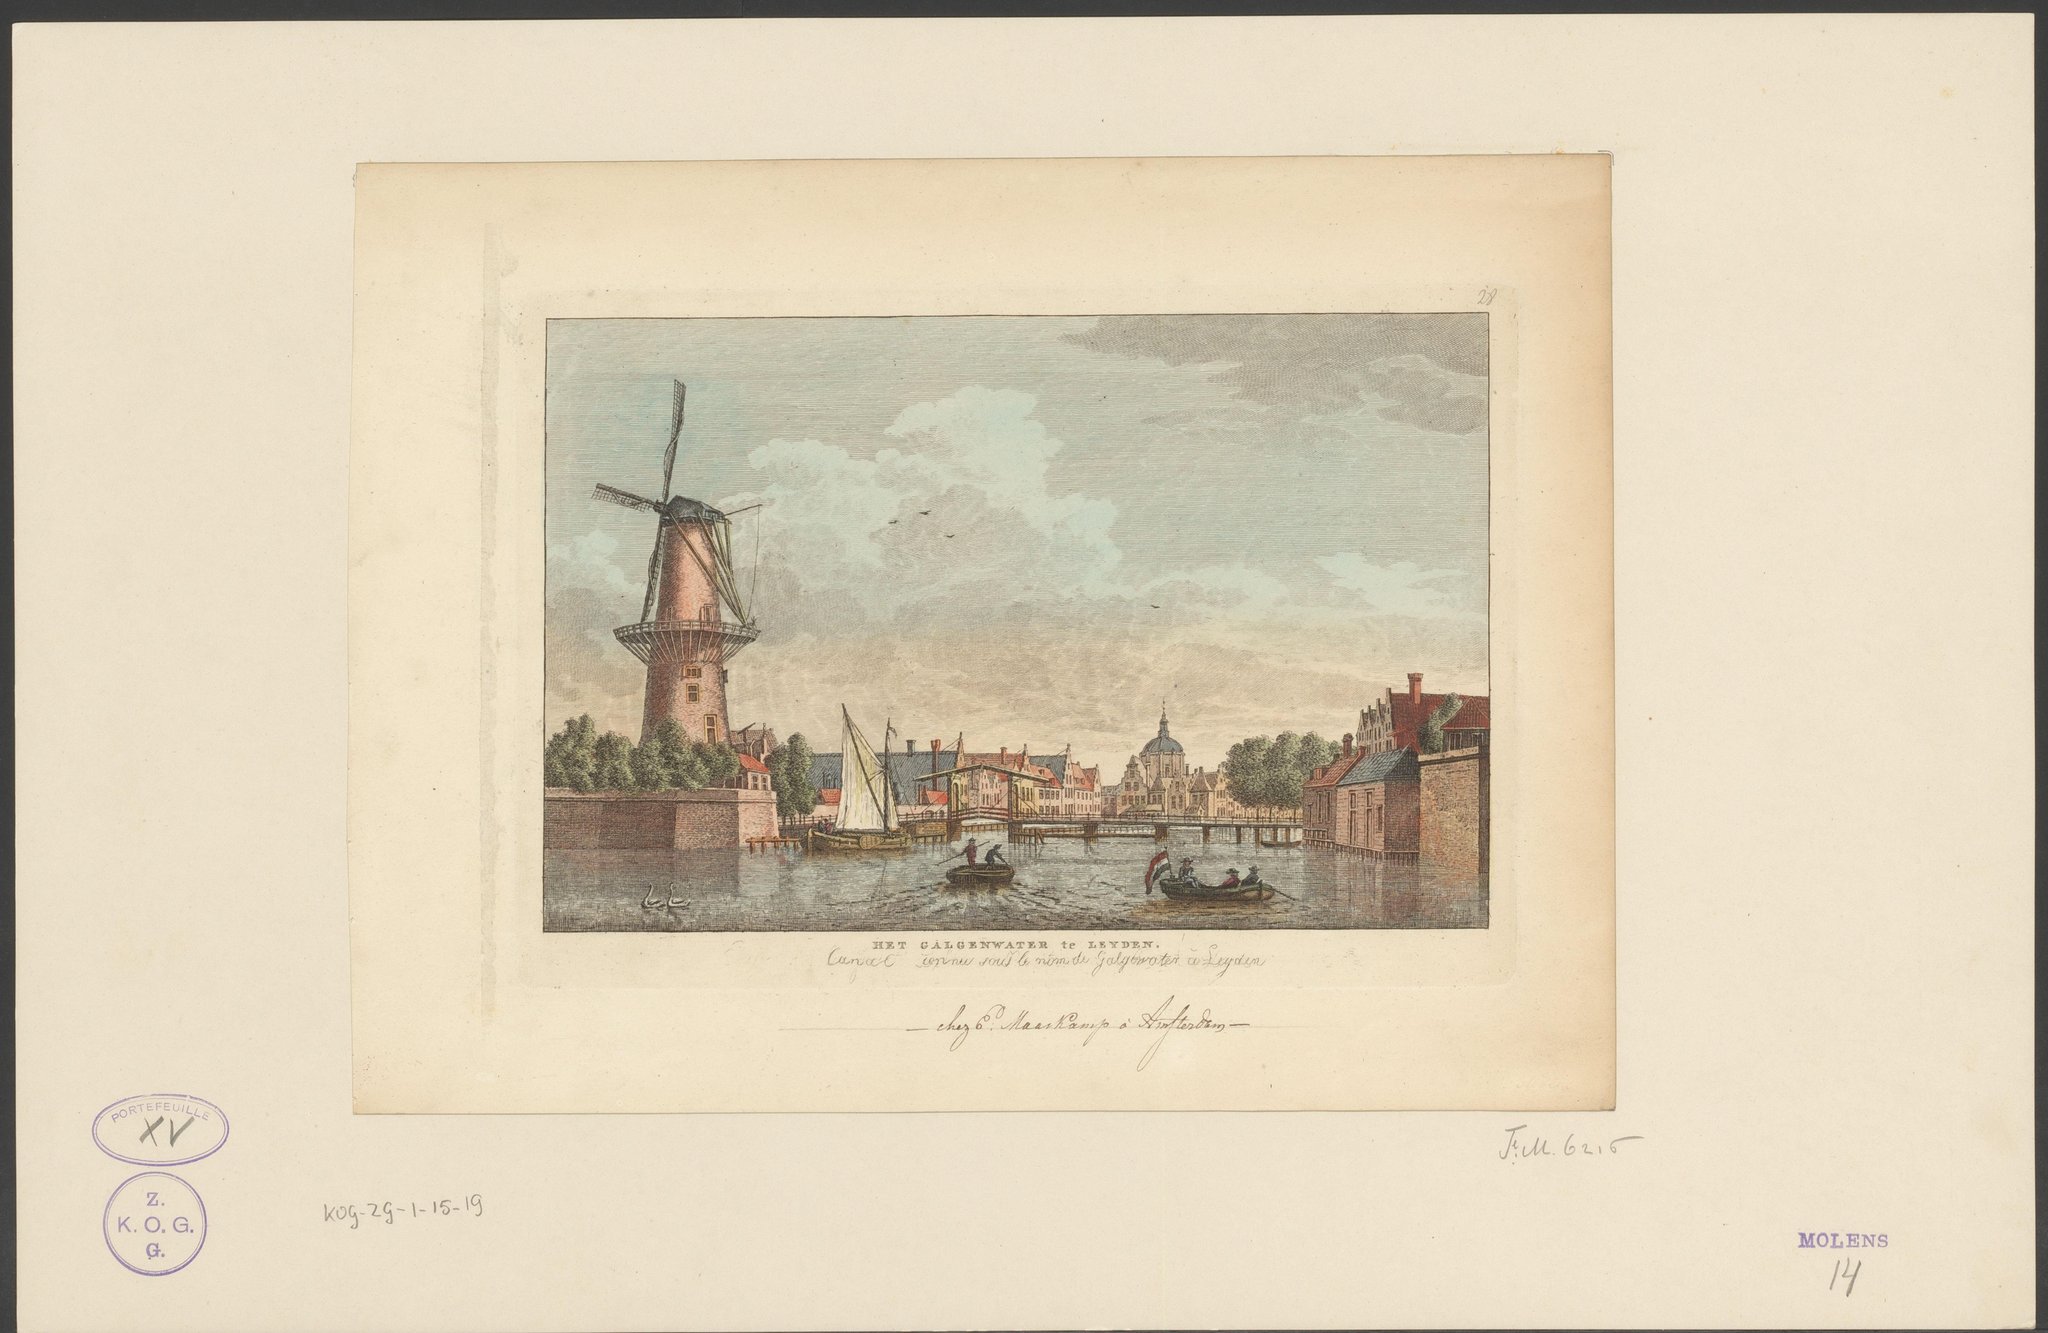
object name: print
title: Galgewater te Leiden, ca. 1790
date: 1786-1792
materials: paper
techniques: engraving, etching, hand coloring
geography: amsterdam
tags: windmill, leiden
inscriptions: stamp, collector's mark: Lugt 1641, stamp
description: Huidige staat van prent uitgegeven als onderdeel van een plaatwerk uit ca. 1824-1825 met 74 (ongenummerde) platen van de belangrijkste topografische gezichten en verschillende zeden en gewoonten in het Verenigd Koninkrijk der Nederlanden, getiteld 'Tableau des principales vues des palais et édifices : représentations et des coutumes et usages, dans les provinces septentrionales du Royaume des Pays-Bas'. Eerdere staat gebruikt in: Vaderlandsche gezichten, of afbeeldingen van den tegenwoordigen staat der Vereenigde Nederlanden (…). Amsterdam: Hendrik Gartman, Willem Vermandel en Jan Willem Smit, 1786-1792. Uitgegeven in afleveringen met ieder een eigen bifolium en inhoudsopgave. Alle prenten in deze publicatie zijn gegraveerd door Carel Frederik Bendorp (I) en, in de meeste gevallen, gebaseerd op tekeningen van Jan Bulthuis.